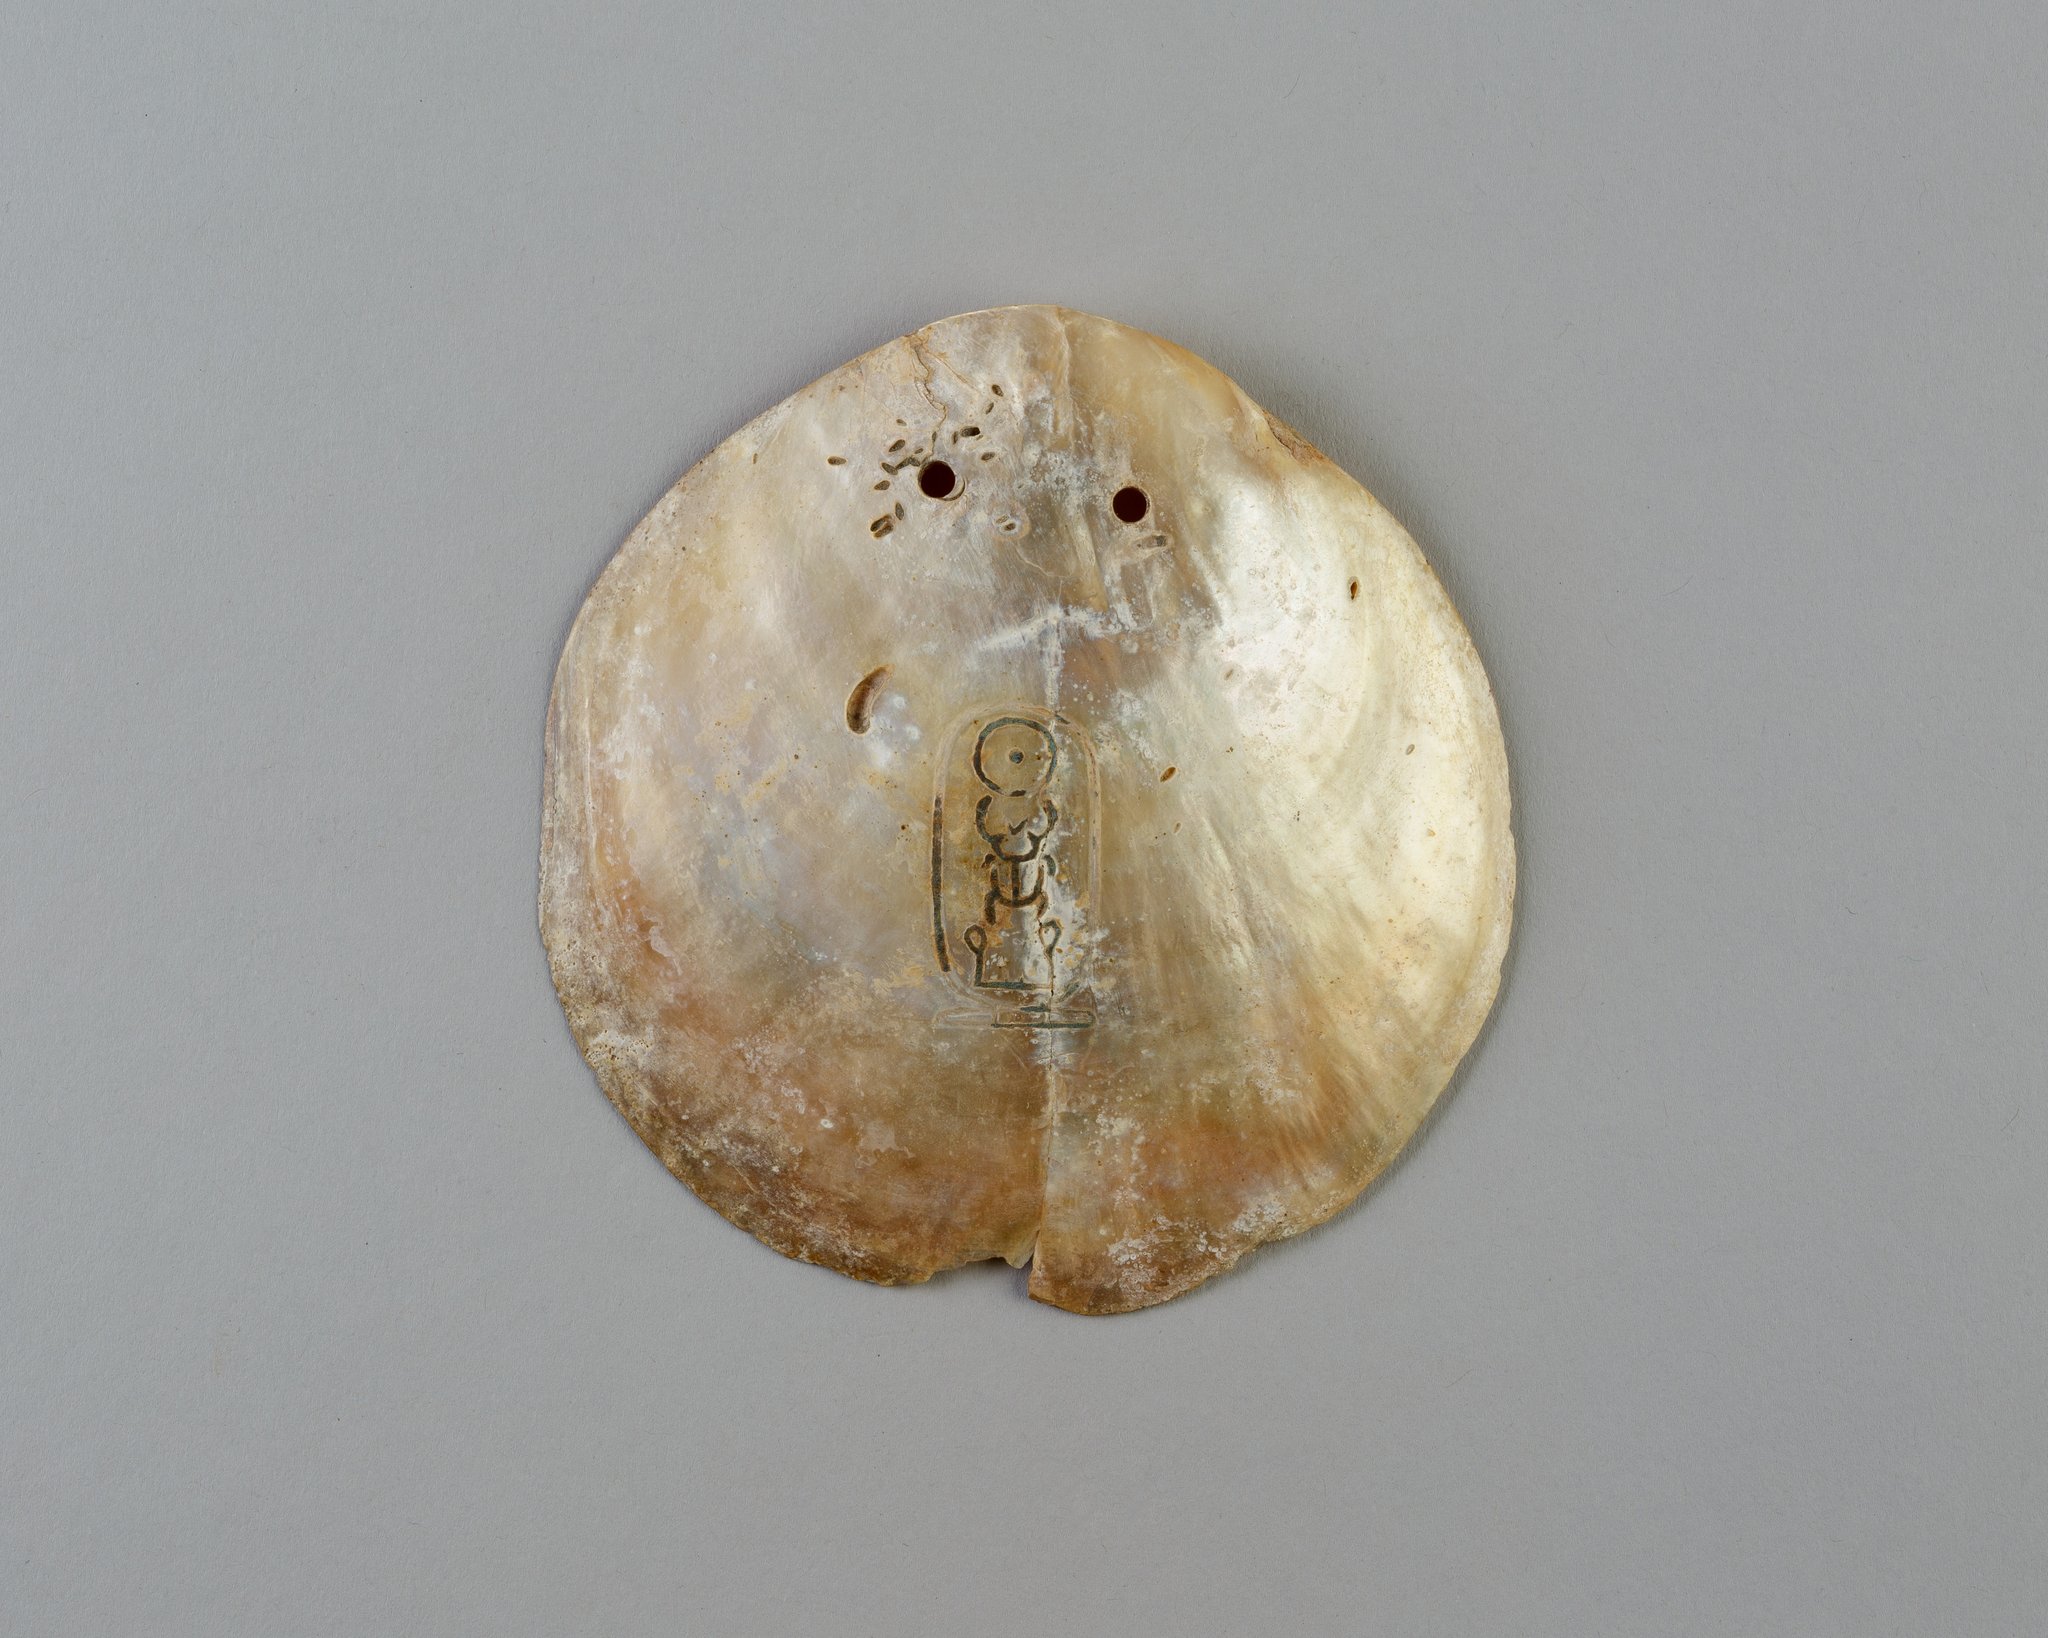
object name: shell, senwosret i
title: Shell Inscribed with the Cartouche of Senwosret I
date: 1981-1550 BCE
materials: shell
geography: egypt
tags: cartouches